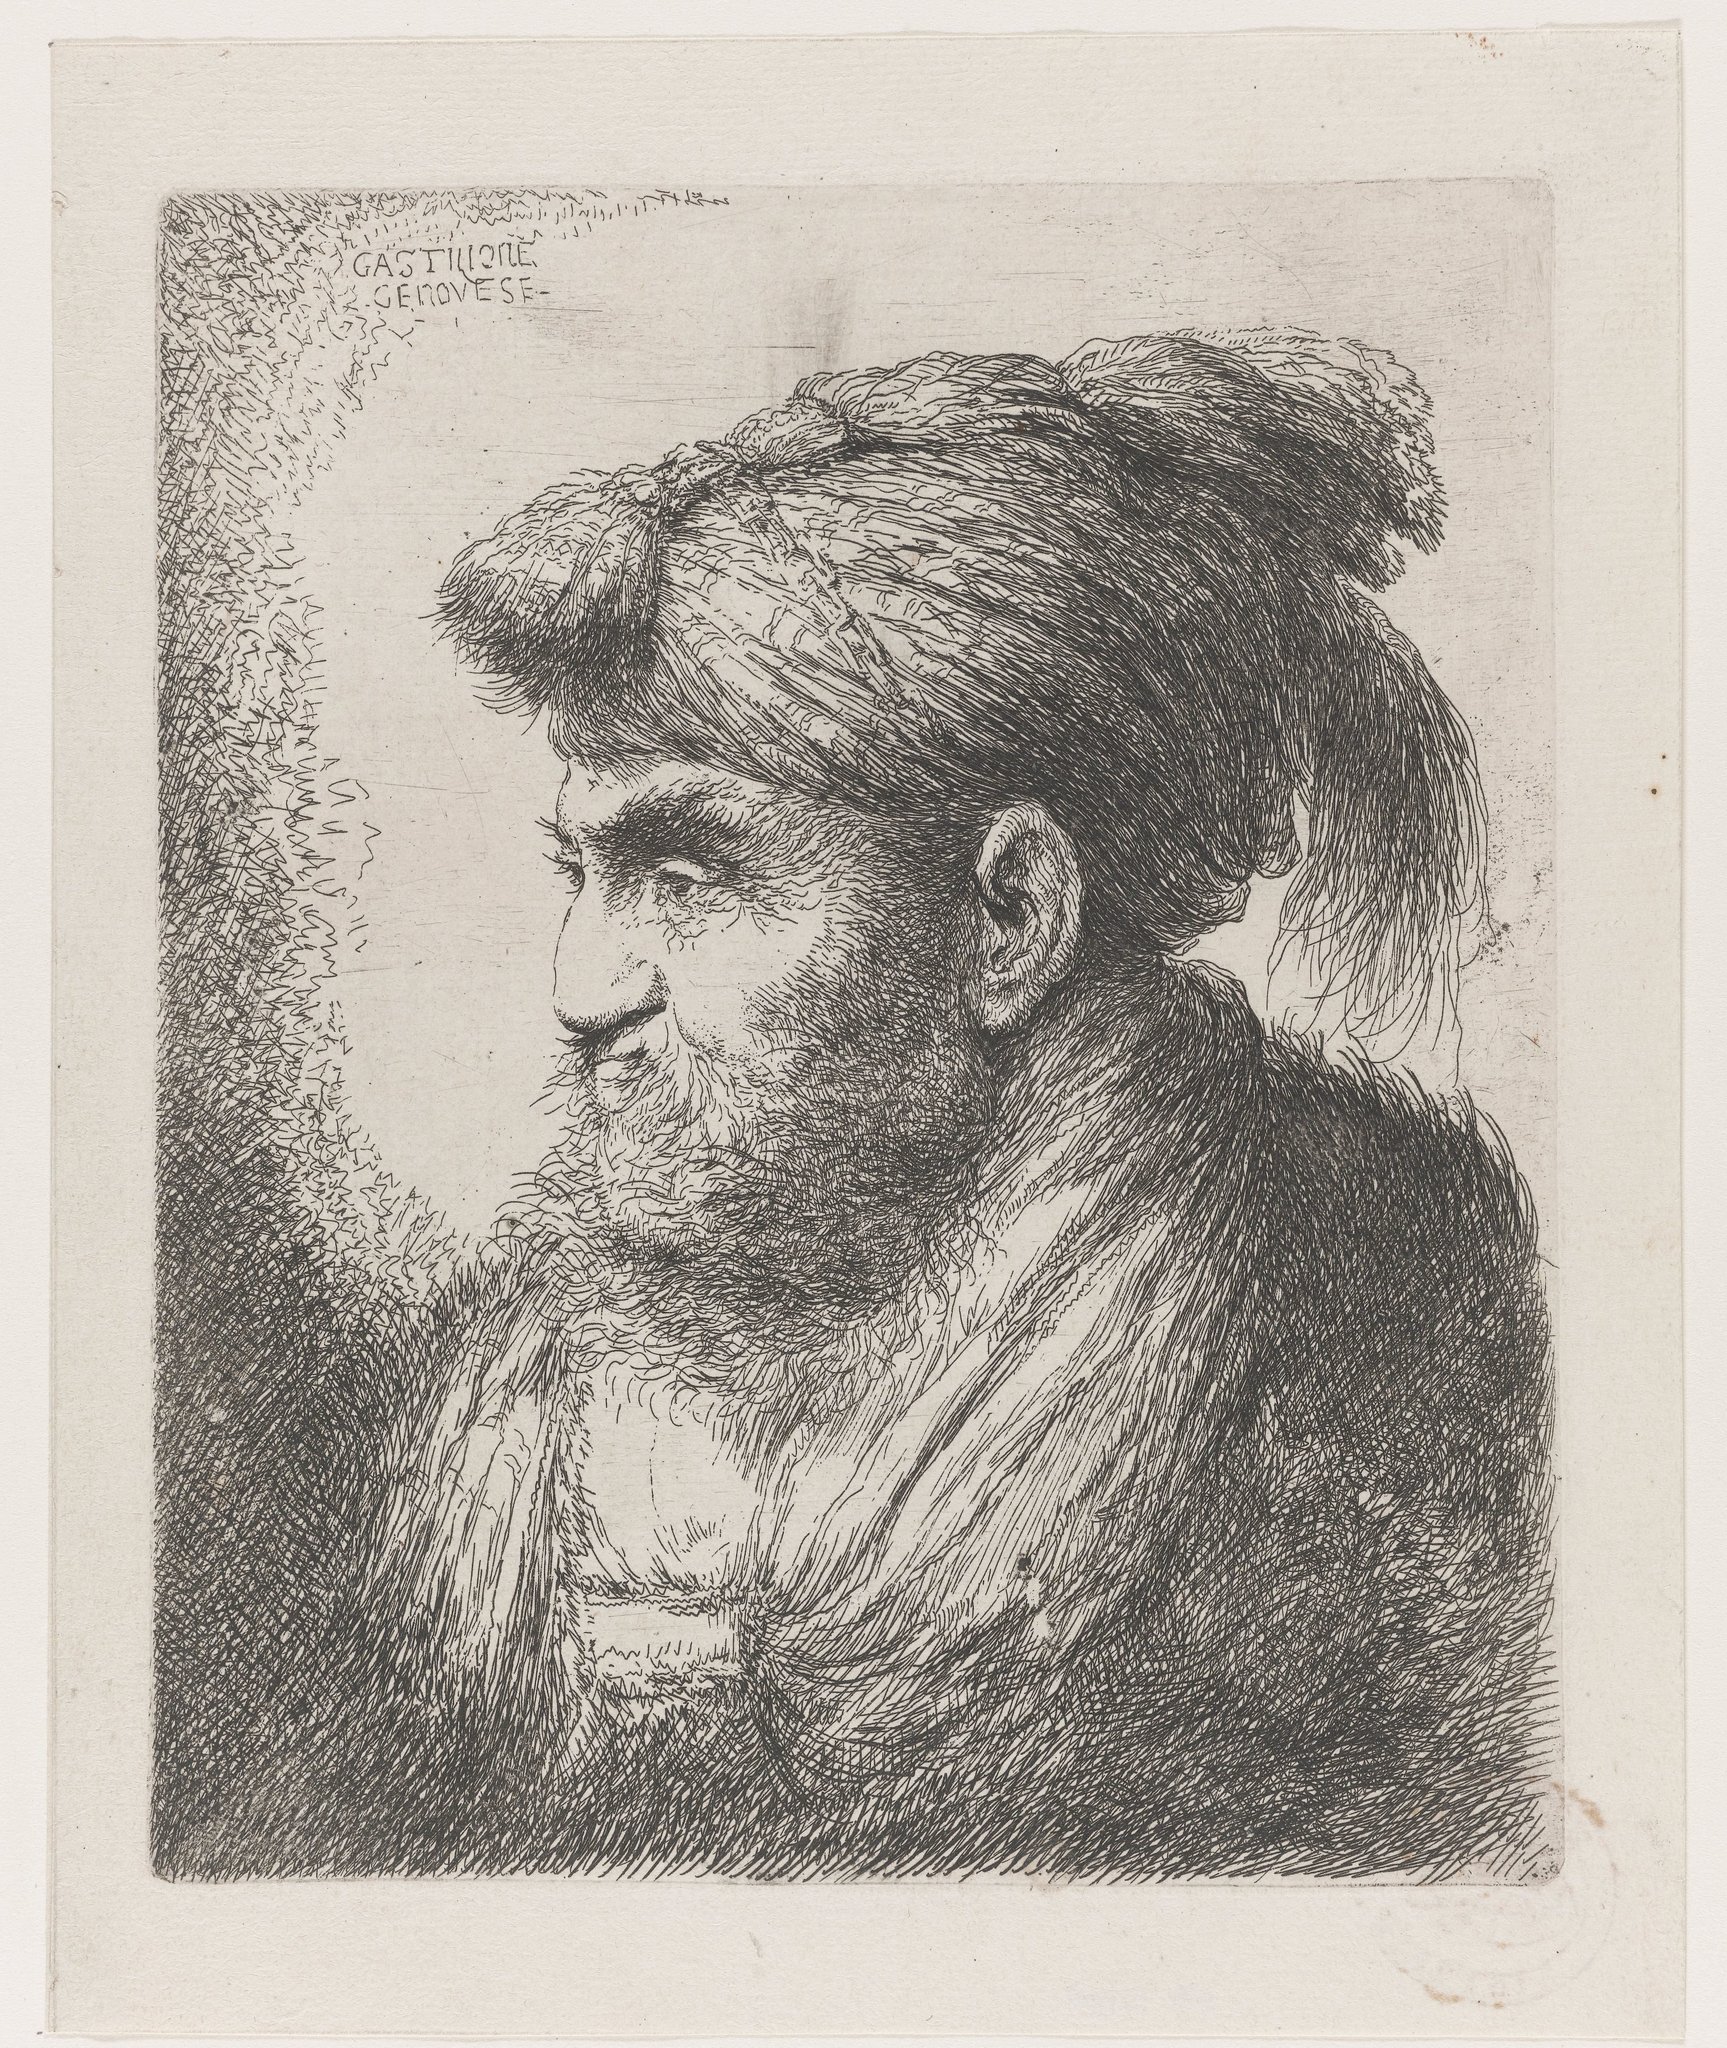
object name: print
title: Grote studie van hoofden met oosterse hoofddeksels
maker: giovanni benedetto castiglione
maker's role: draughtsman, print maker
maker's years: 1610-1665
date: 1645-1650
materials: paper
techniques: etching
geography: italy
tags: head (human), head-gear: turban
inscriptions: collector's mark: Lugt 240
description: Een hoofd van een man oude man met baard, en profil. Hij draagt een tulband met een kwast aan de voorzijde. Prent uit een serie van zes.